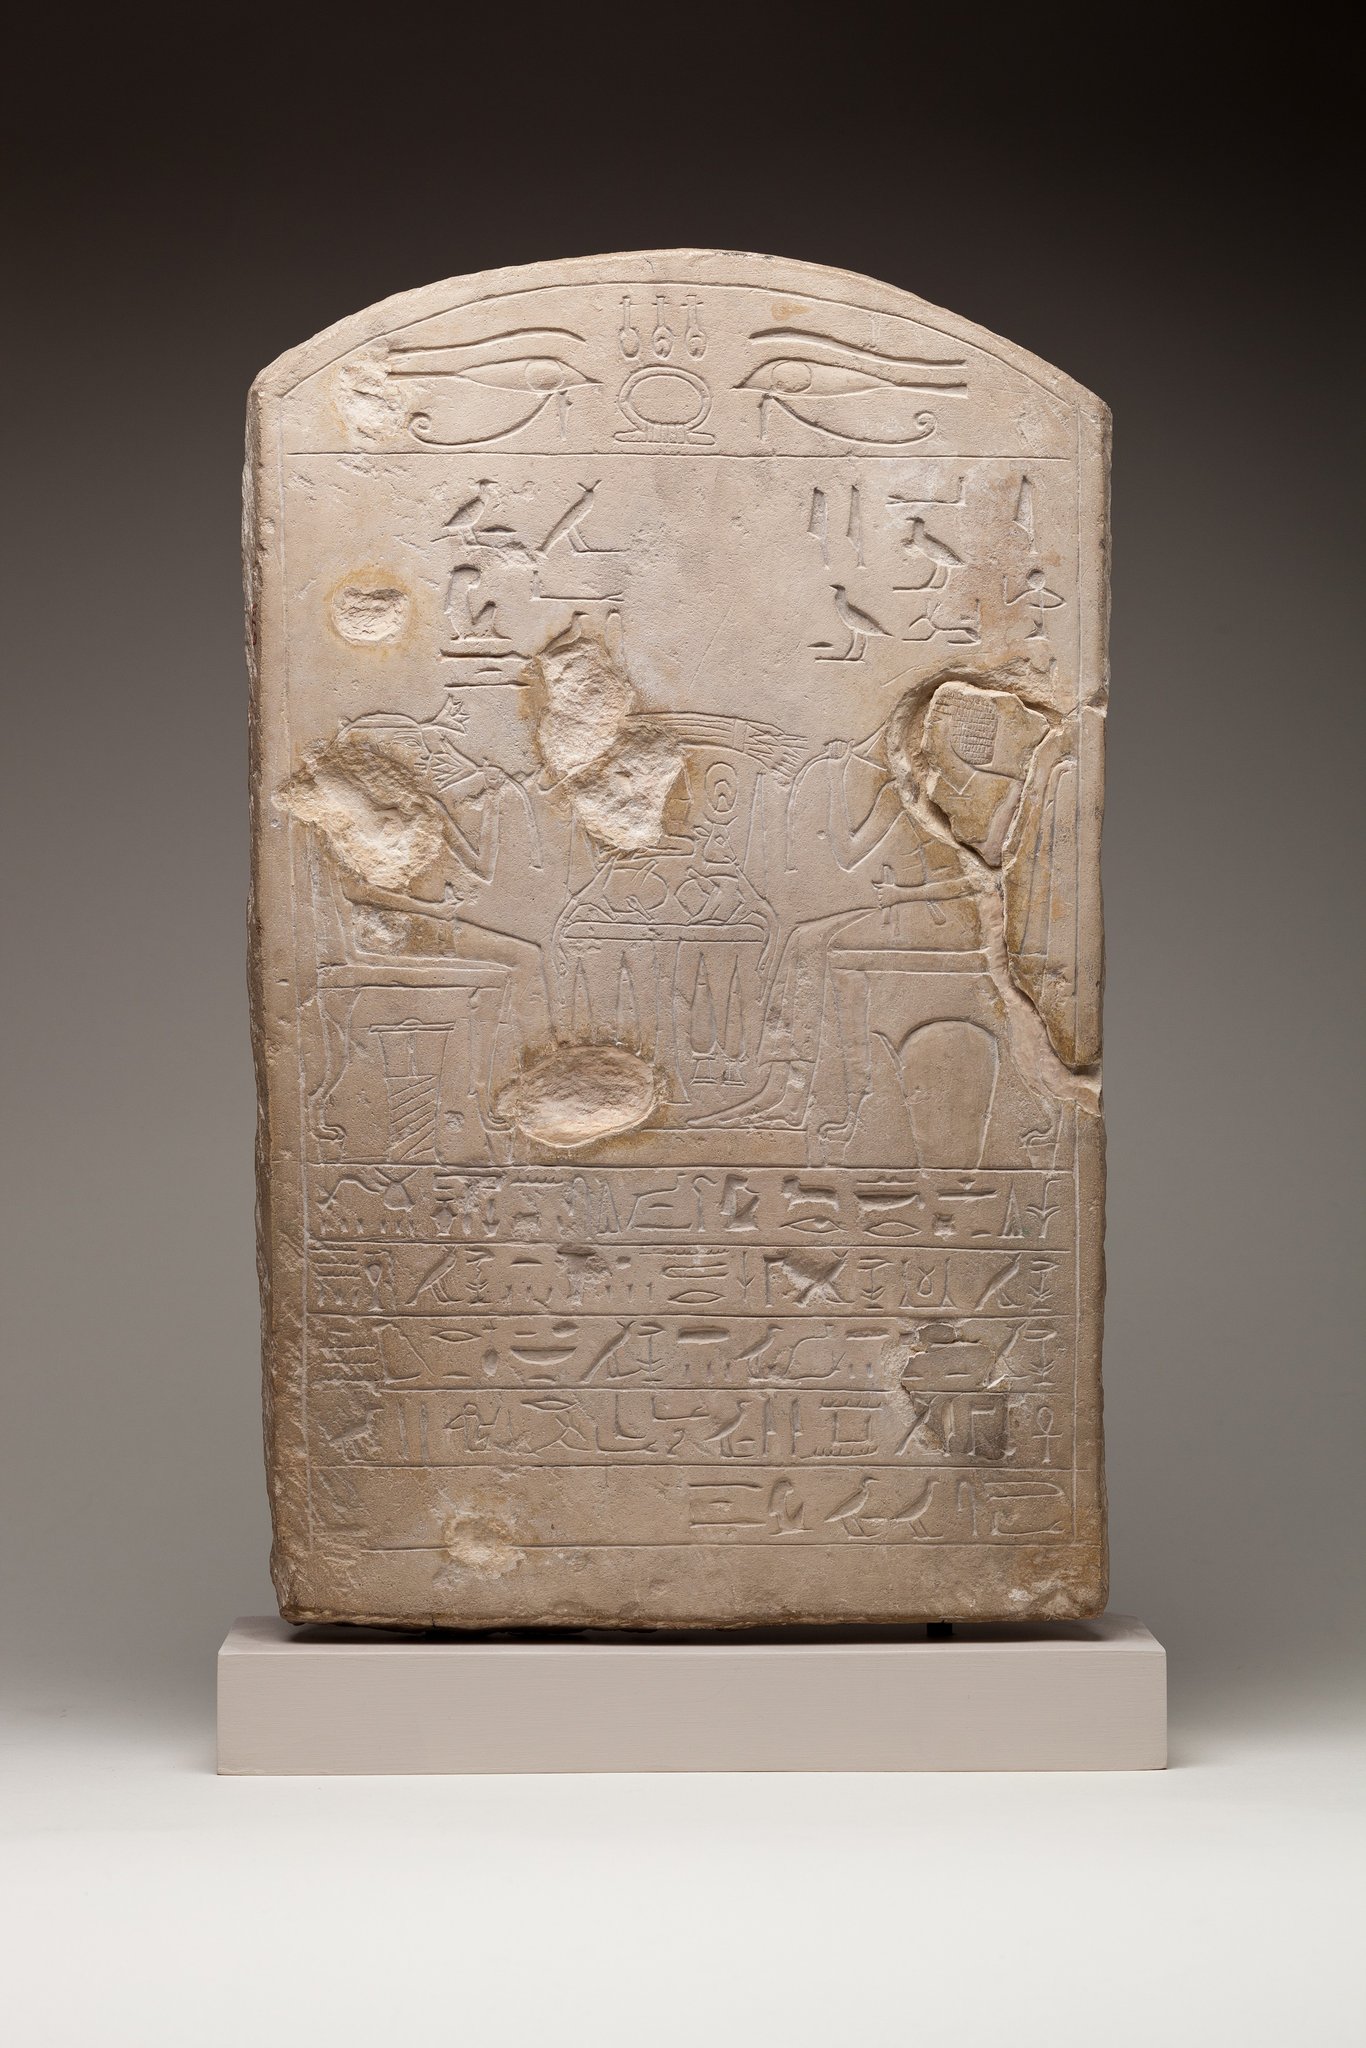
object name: stela, itusuti, itubaal, masutu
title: Stela of Itubaal and Masutu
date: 1550-1400 BCE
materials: limestone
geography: egypt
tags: hieroglyphs